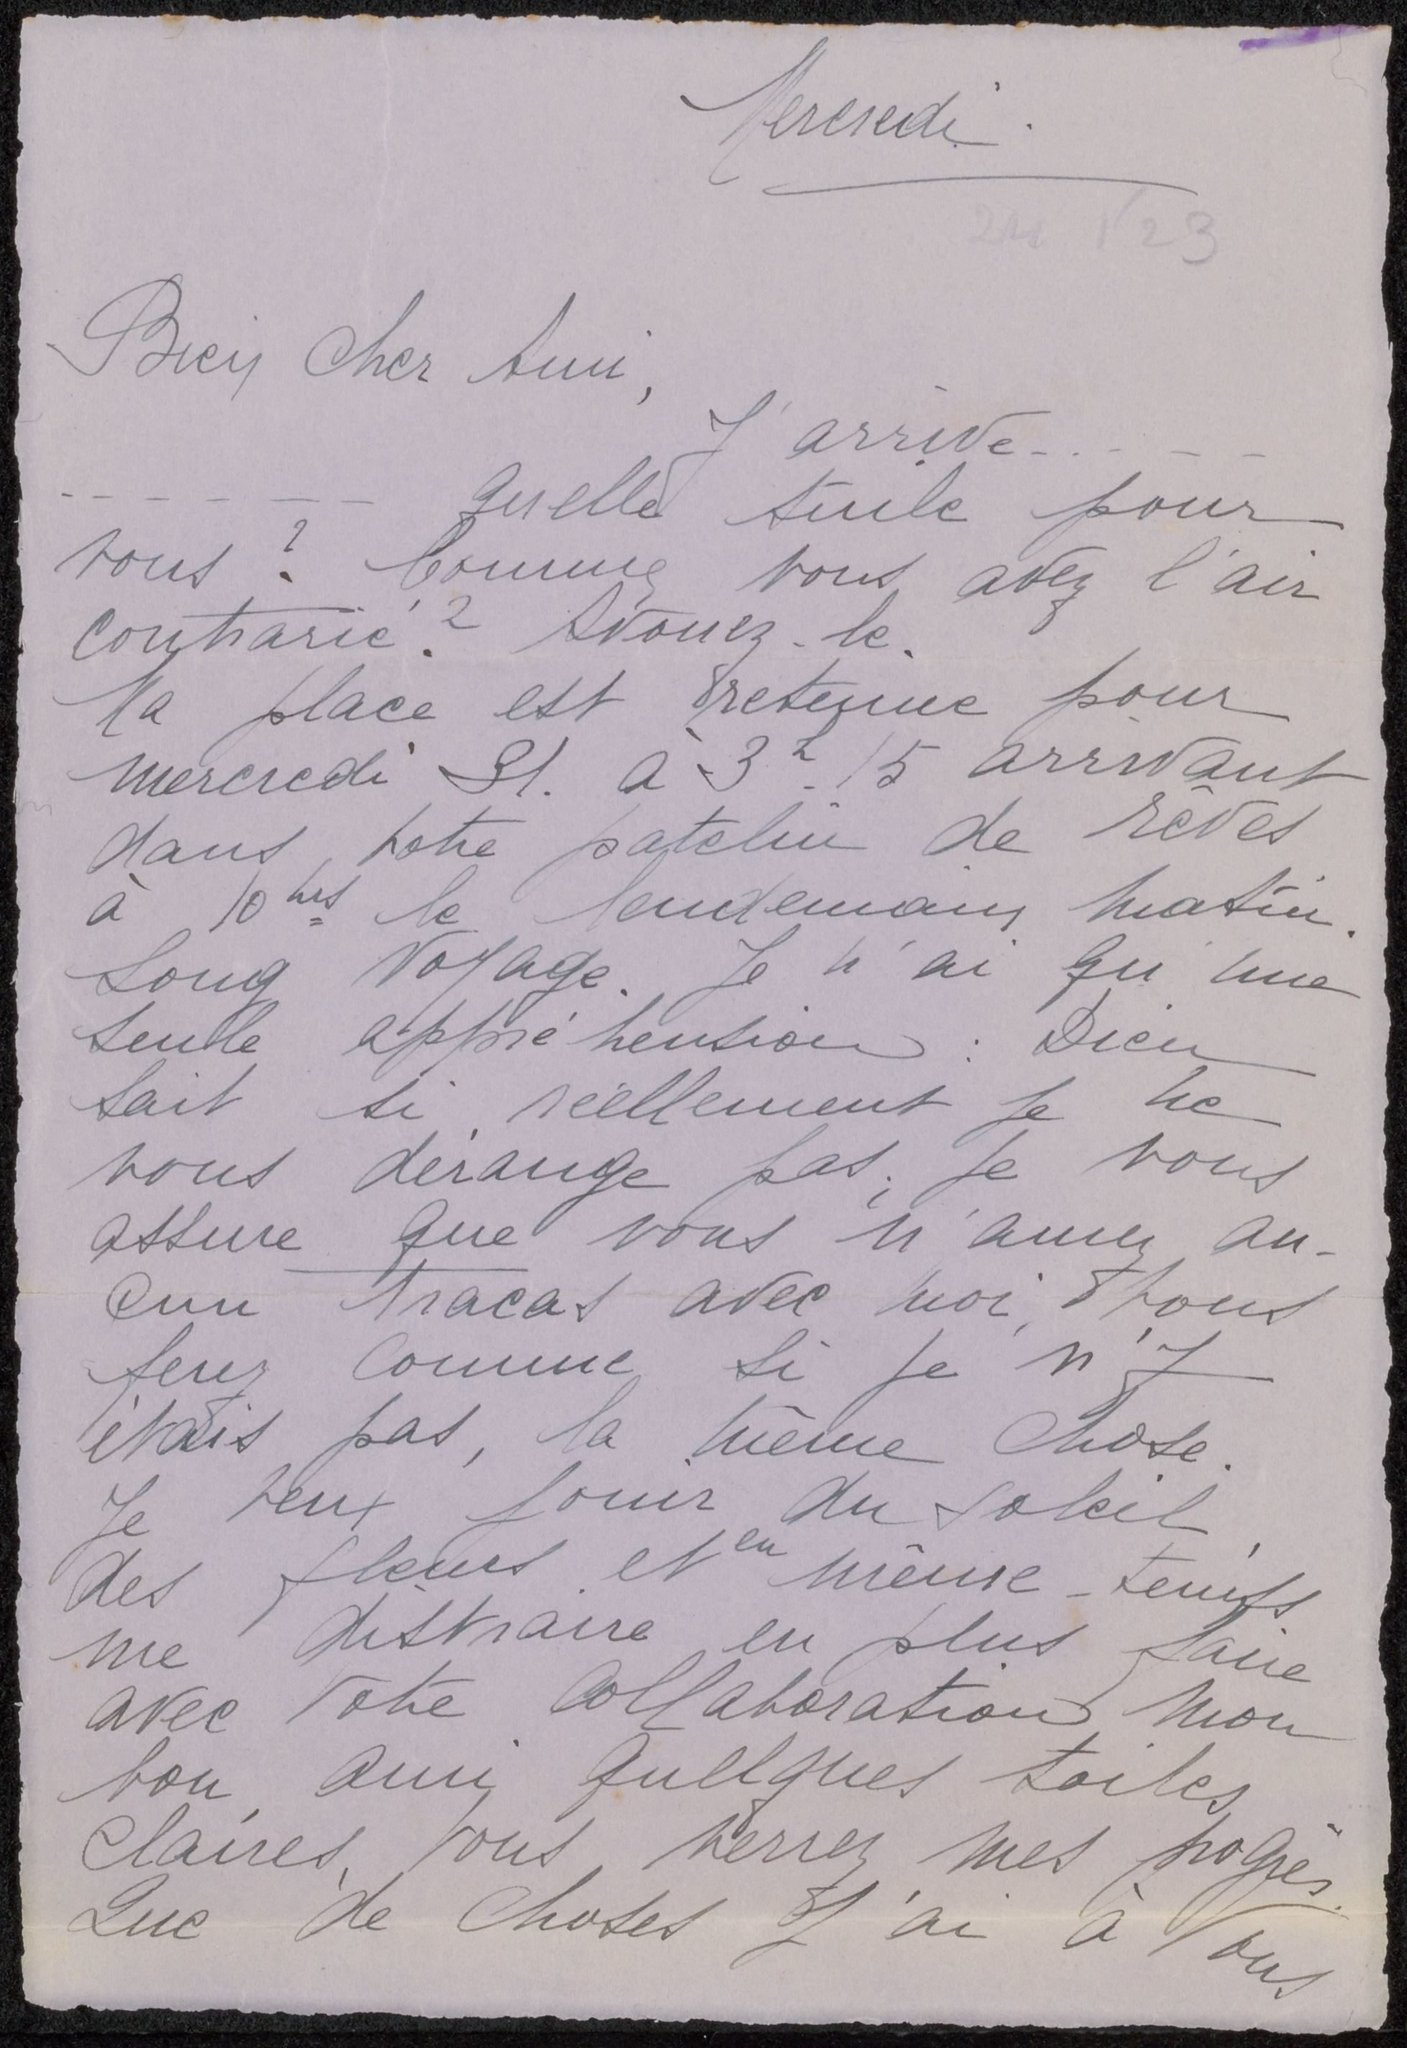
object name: letter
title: Brief aan Philip Zilcken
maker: rose imel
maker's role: draughtsman, painter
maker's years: 1901-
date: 1911-1930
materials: ink, paper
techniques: pen, writing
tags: the hague, painter, draughtsman, philip zilcken, the graphic arts, travelling; tourism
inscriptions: collector's mark: ‘RPK’